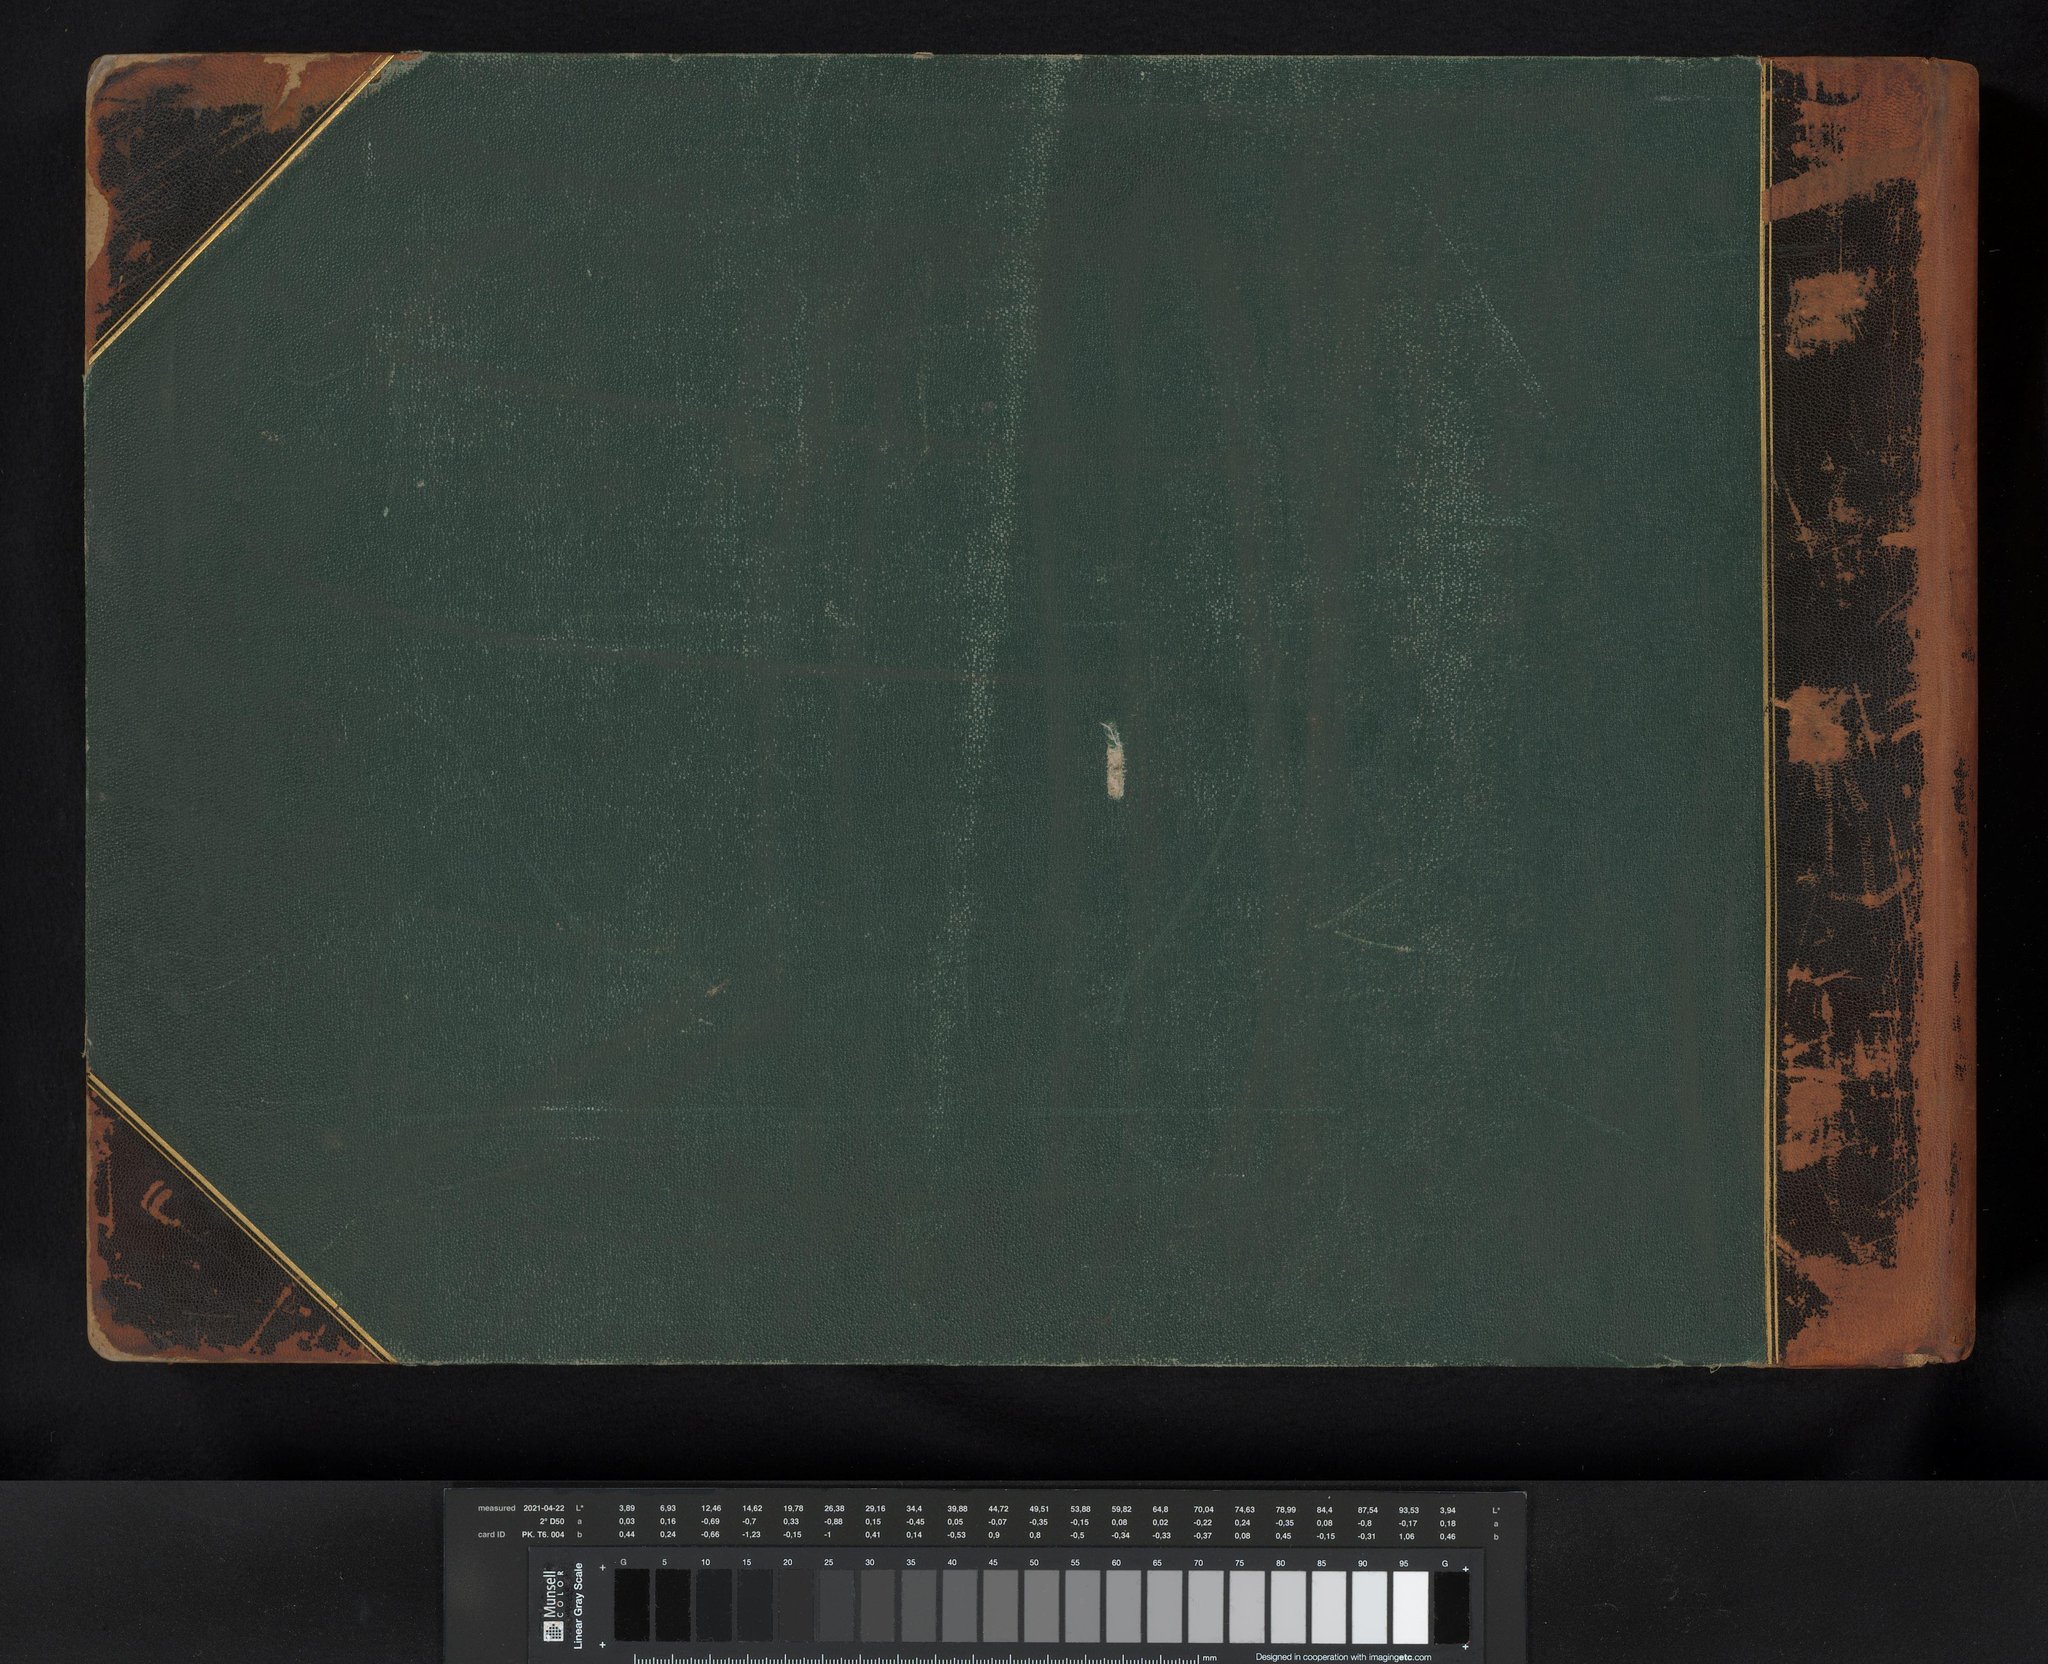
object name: album leaf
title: Ontginning op Kanopan Oeloe, 1938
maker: Anonymous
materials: cardboard, photographic support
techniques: gelatin silver print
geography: sumatra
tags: plantation, (non-fruit) products of plants or trees: rubber, sumatra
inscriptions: inscription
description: Blad met vier foto's van ontginning voor aanplant van rubberbomen op Kanopan Oeloe, april-augustus 1938. Onderdeel van het fotoalbum over de plantages Leidong West en Kanopan Oeloe van de Cultuur Maatschappij Leidong West op Sumatra in de jaren 1925-1939.